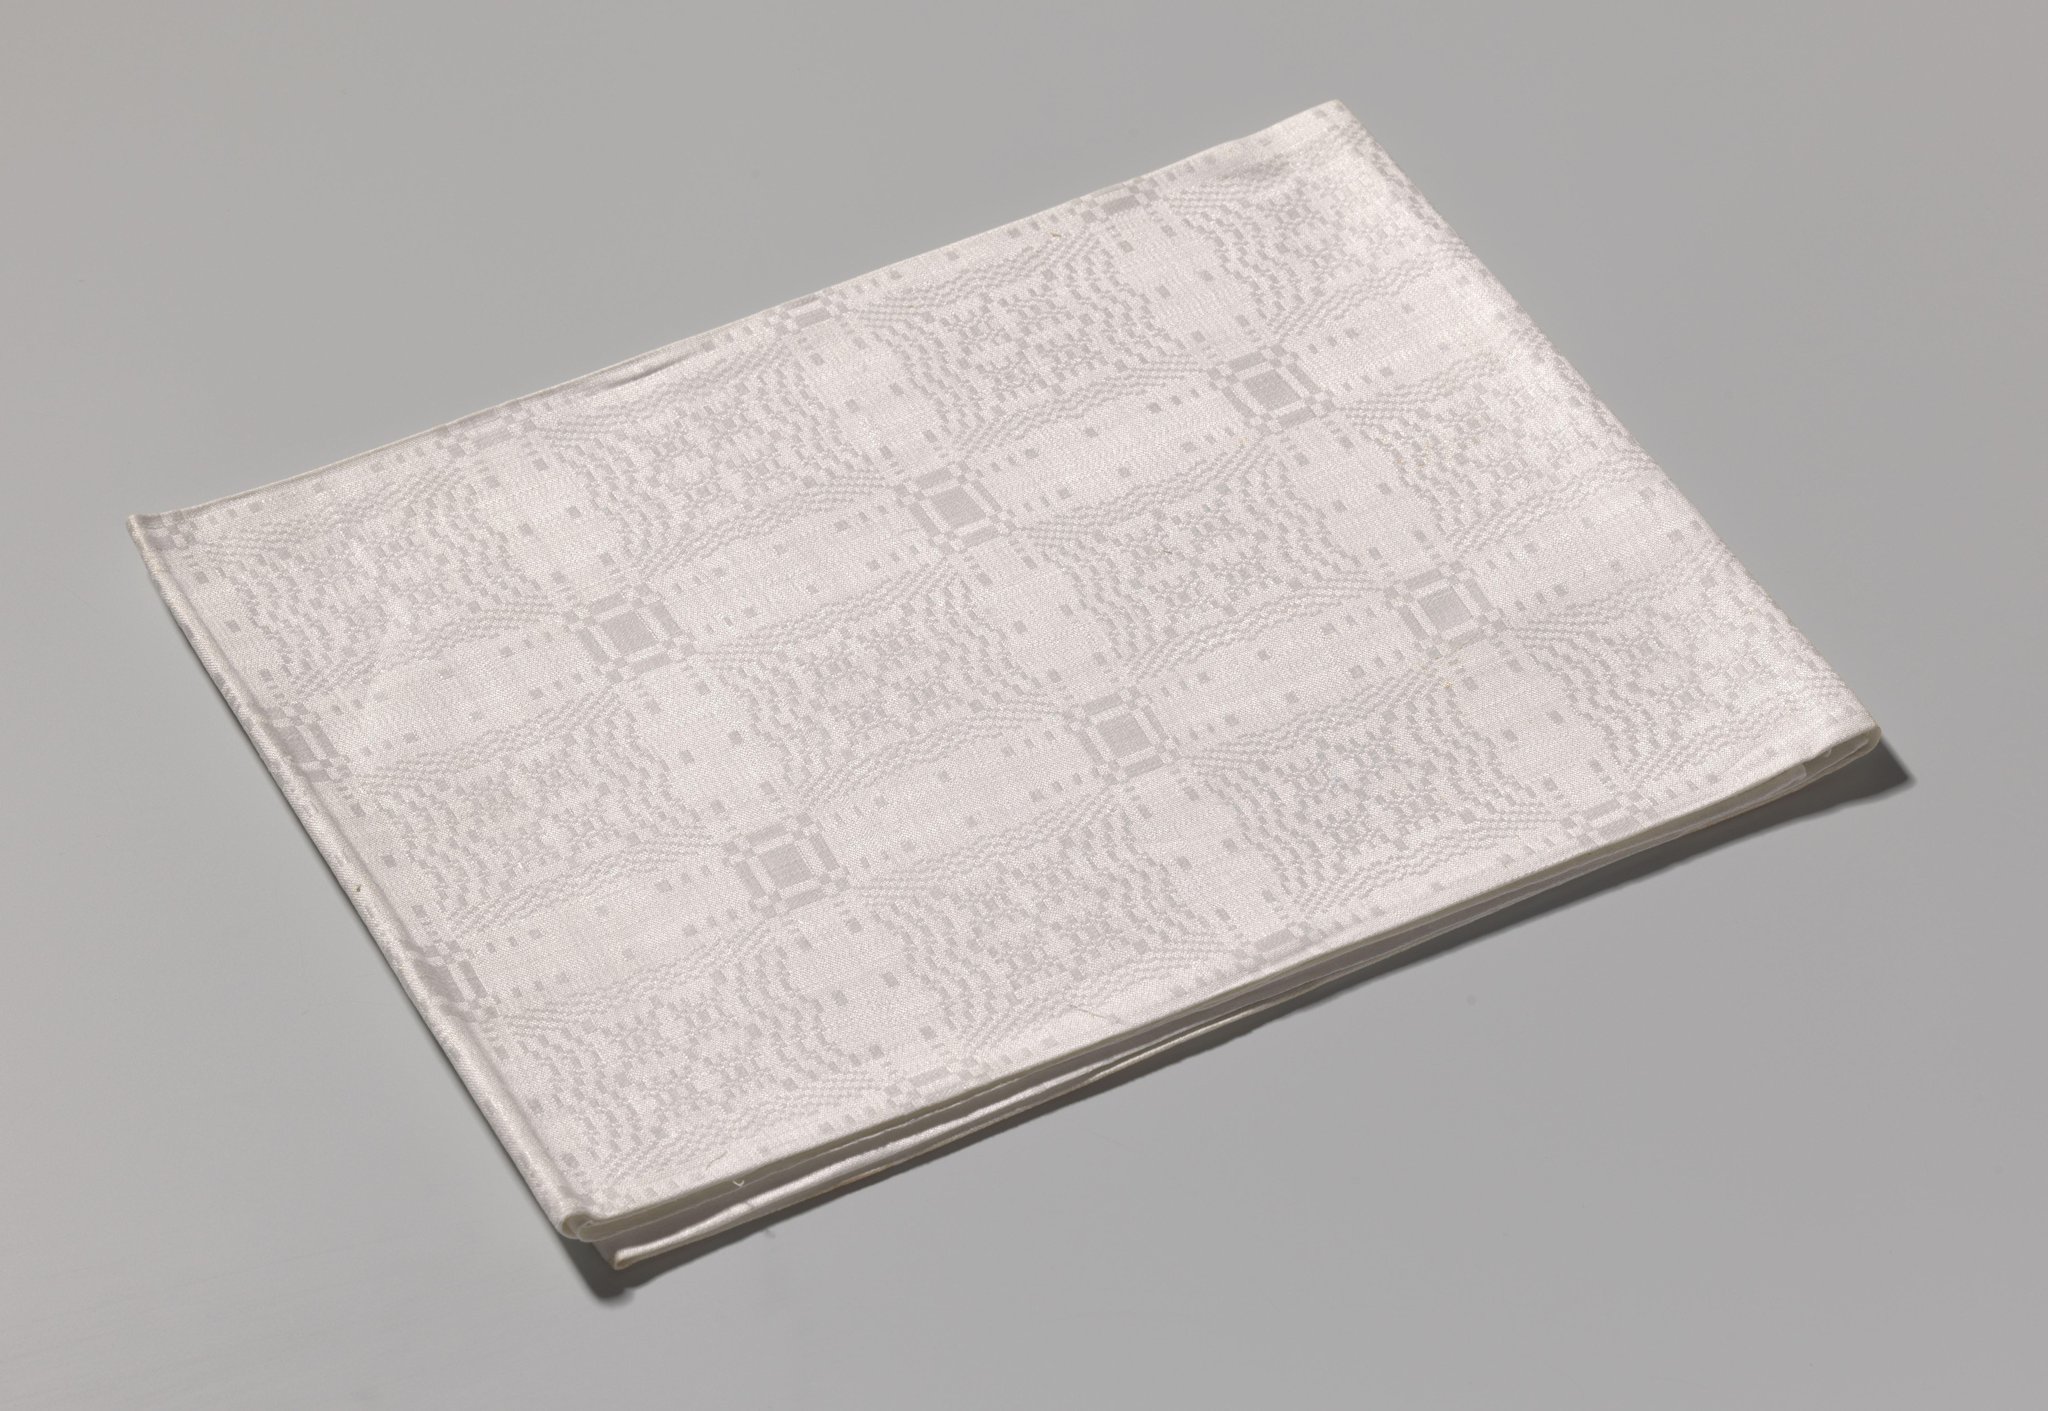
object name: napkin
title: Servet van linnen met pellenpatroon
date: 1400-1950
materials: linen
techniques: peeled fabric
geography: northern netherlands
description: Wit linnendamasten servet met pellenpatroon, merk kroon IS en 96.